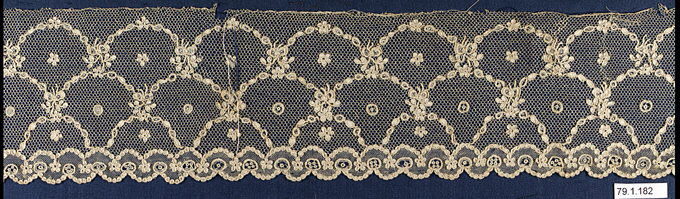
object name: strip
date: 1767-1800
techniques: lace